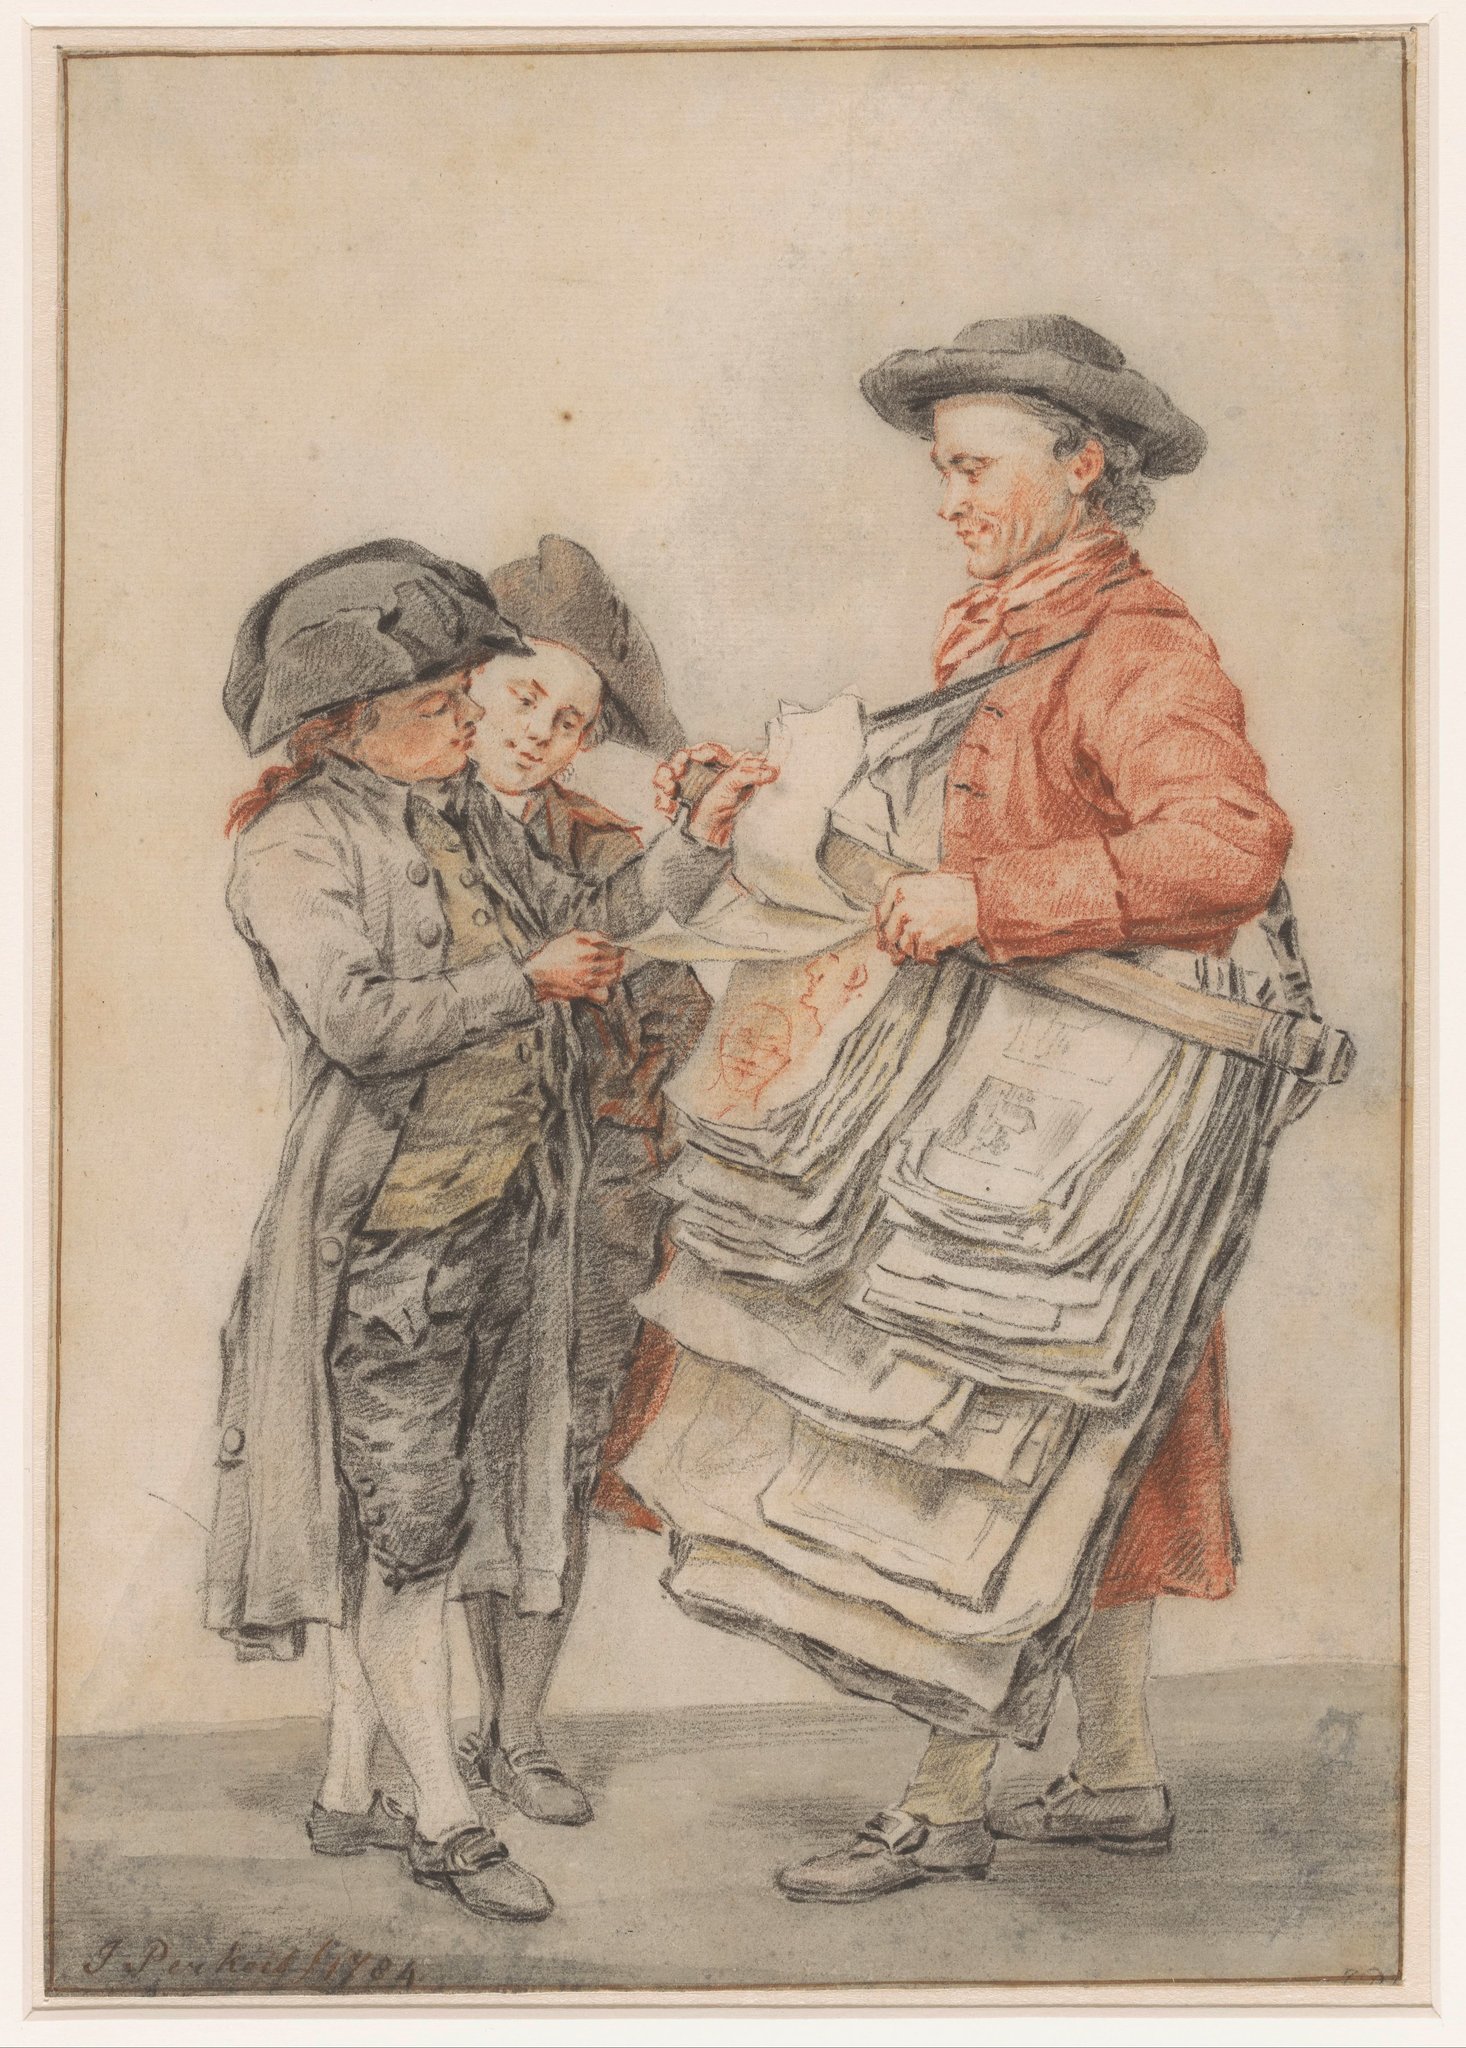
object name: drawing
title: The Print Seller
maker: jacob perkois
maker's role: draughtsman, print maker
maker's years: 1756-1804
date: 1784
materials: chalk, paper, watercolor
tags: pedlar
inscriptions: date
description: Two boys peruse prints, while the seller patiently looks on. Will the young connoisseur buy anything? This genre scene is by Jacobus Perkois, founder of the Middelburg drawing academy. In this work he creates a colourful scene using only black and white chalk, with touches in watercolour. The subtle expression on the print seller’s face, as if he were refraining from making any unnecessary comments, demonstrates Perkois’ eye for detail.